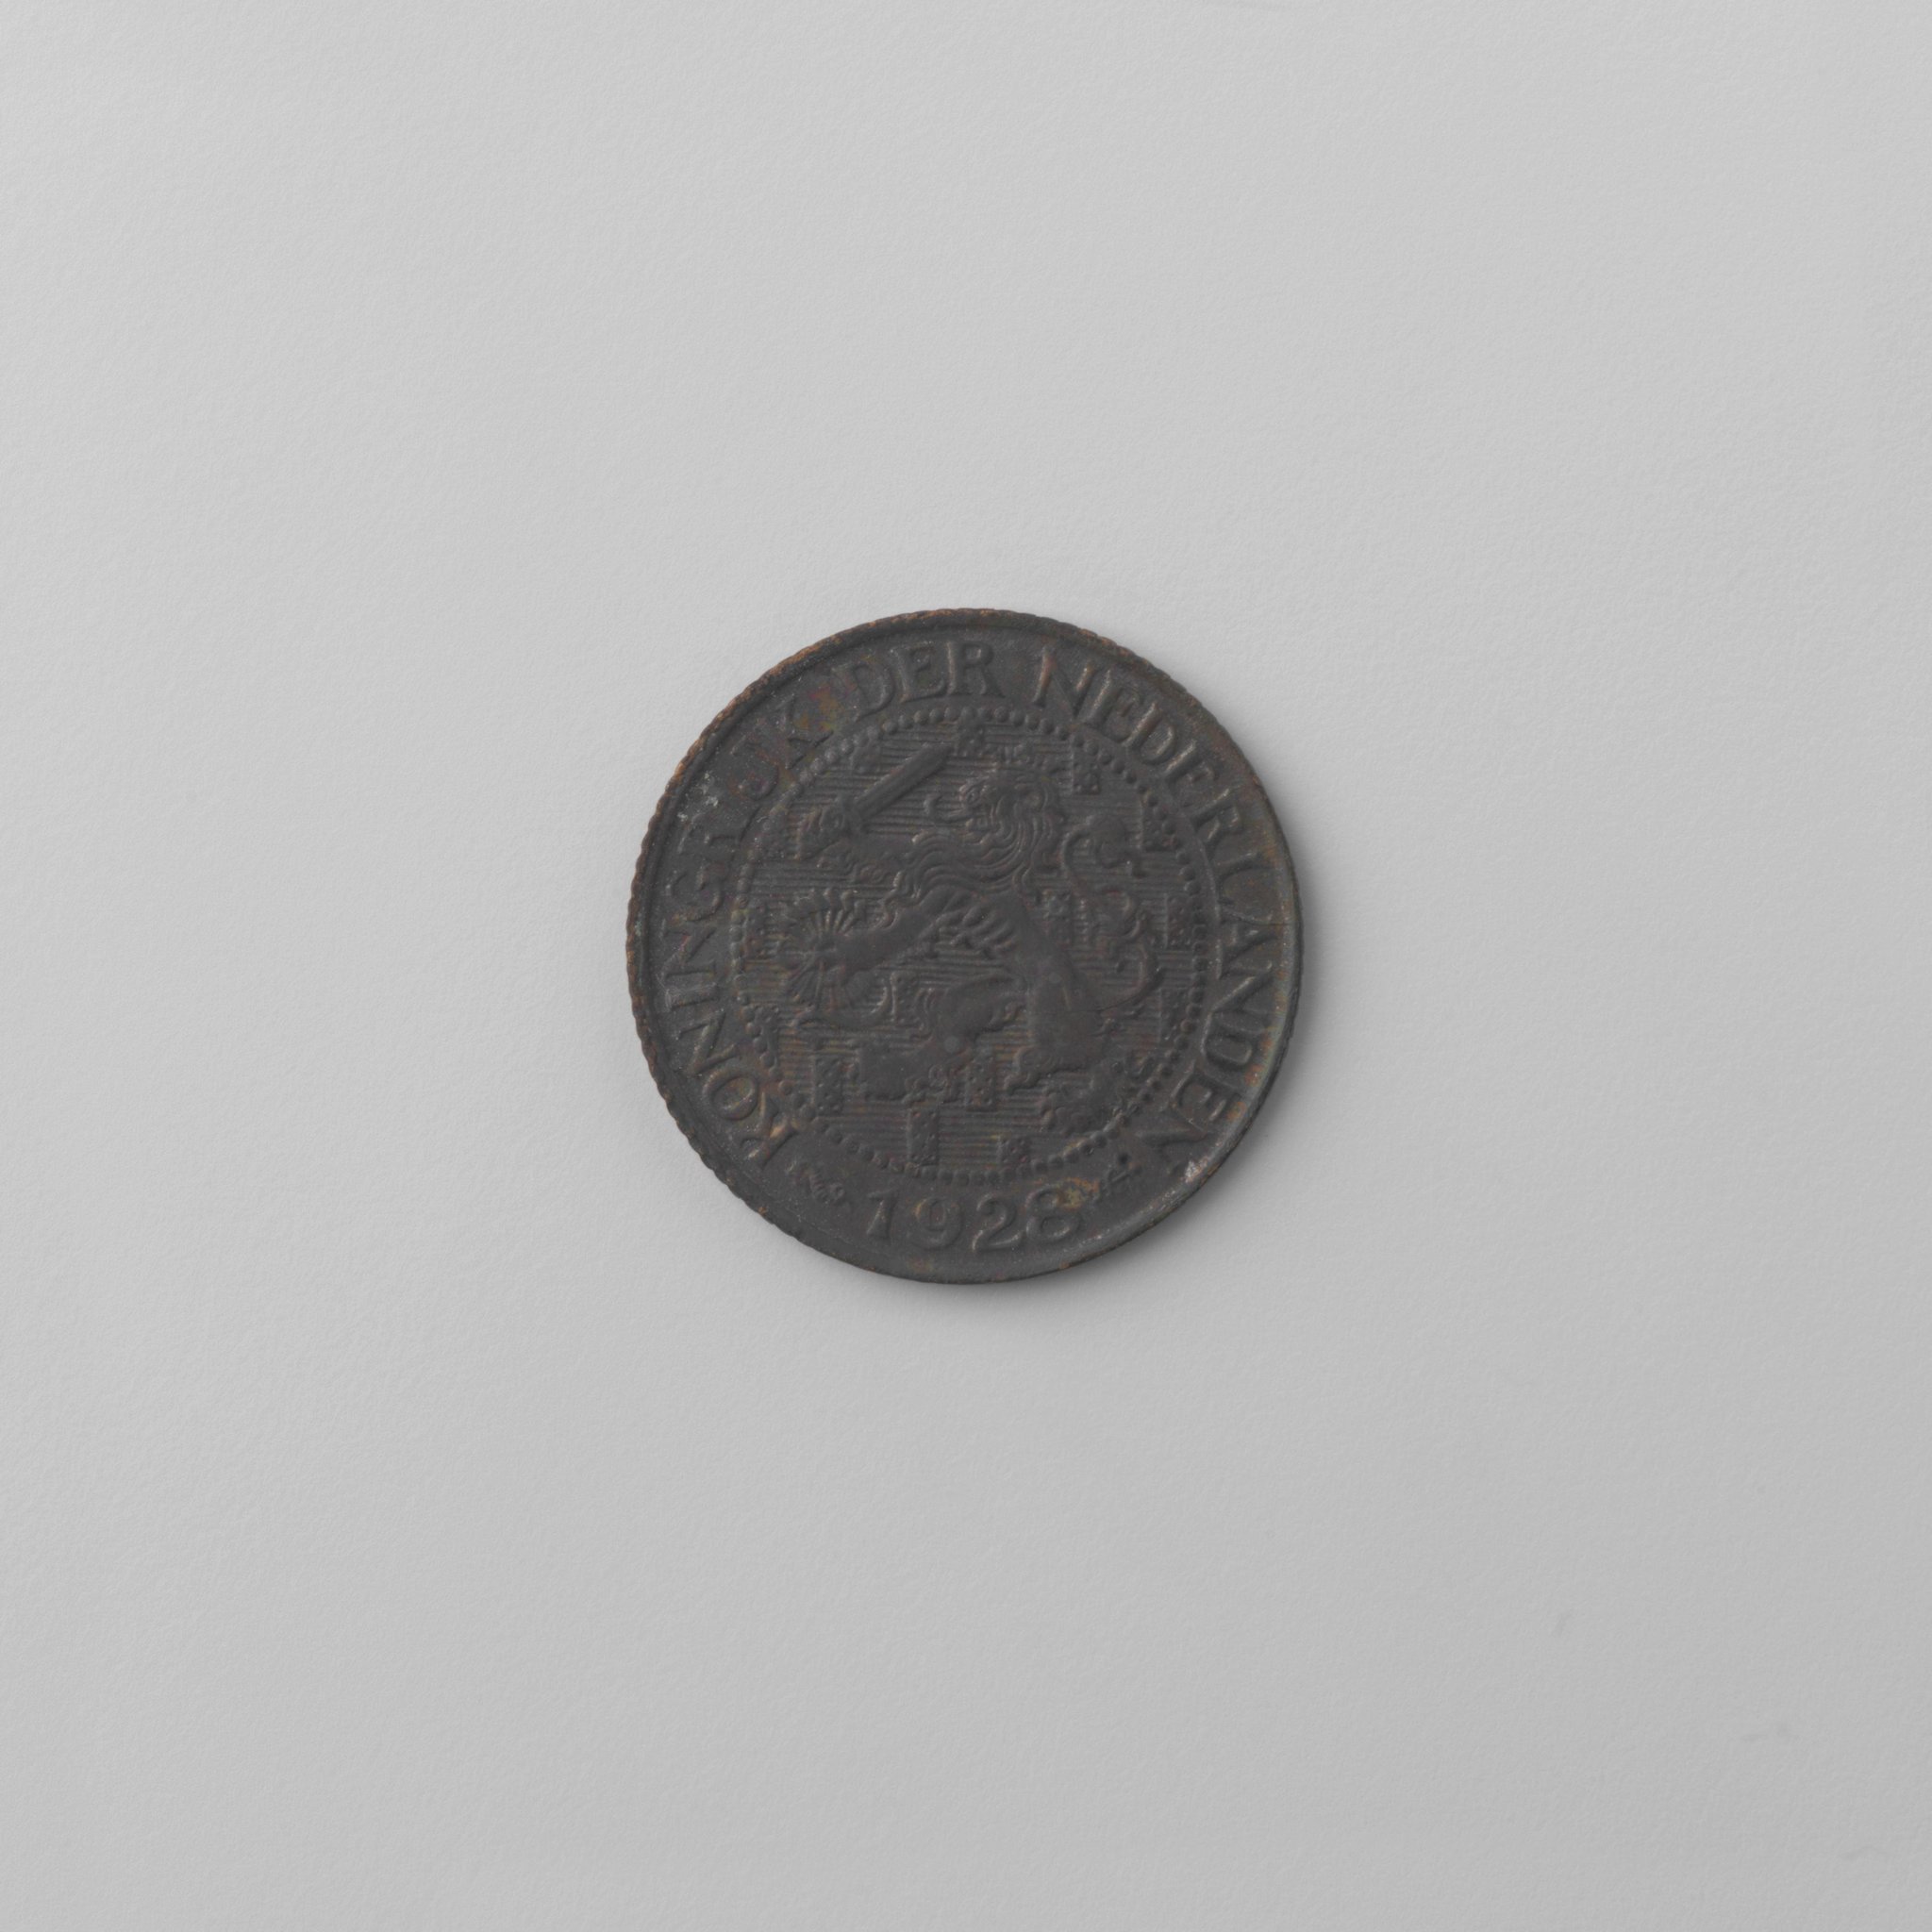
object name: coin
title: Nederlandse cent,1928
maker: wilhelmina of the netherlands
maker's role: print maker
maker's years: 1880-1962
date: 1928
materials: bronze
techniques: striking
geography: utrecht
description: Bronzen munt. Voorzijde: in een veld rijkswapen. Jaartal onderaan in omschrift. Keerzijde: binnen twee samengebonden oranjetakken waarde-aanduiding 1 cent. Kartelrand.